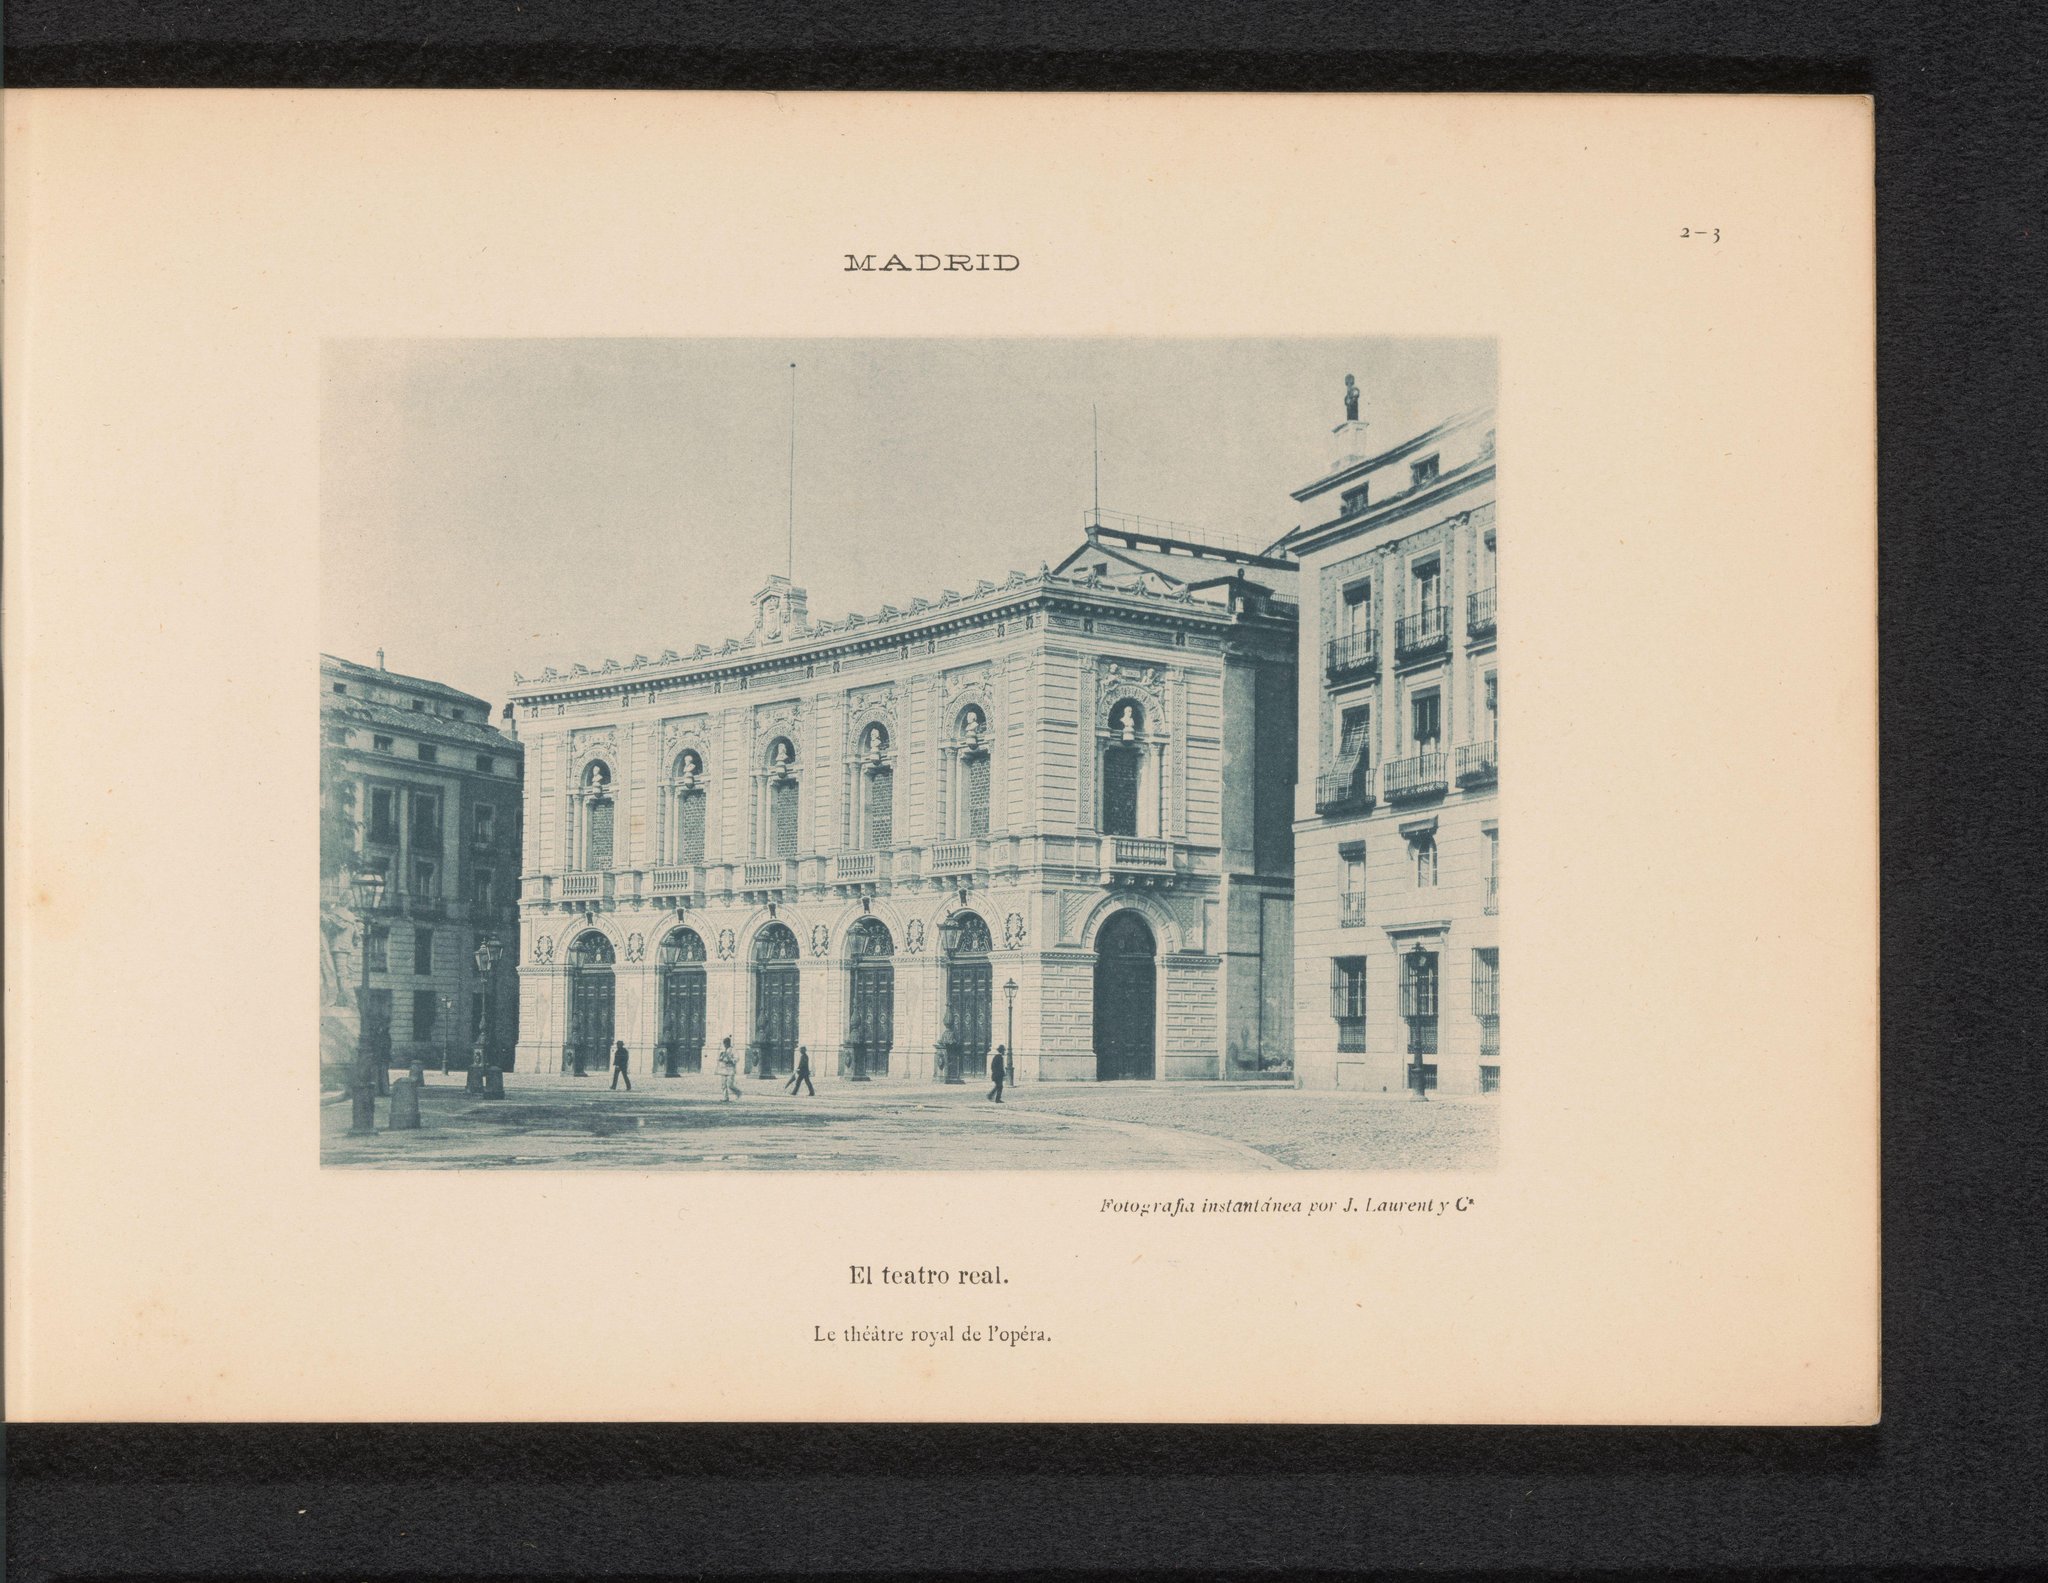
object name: page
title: El teatro real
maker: juan laurent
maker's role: publisher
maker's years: 1816-1896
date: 1880-1890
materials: paper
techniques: photograph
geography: madrid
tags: theatre (building)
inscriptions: number: ‘2-3’